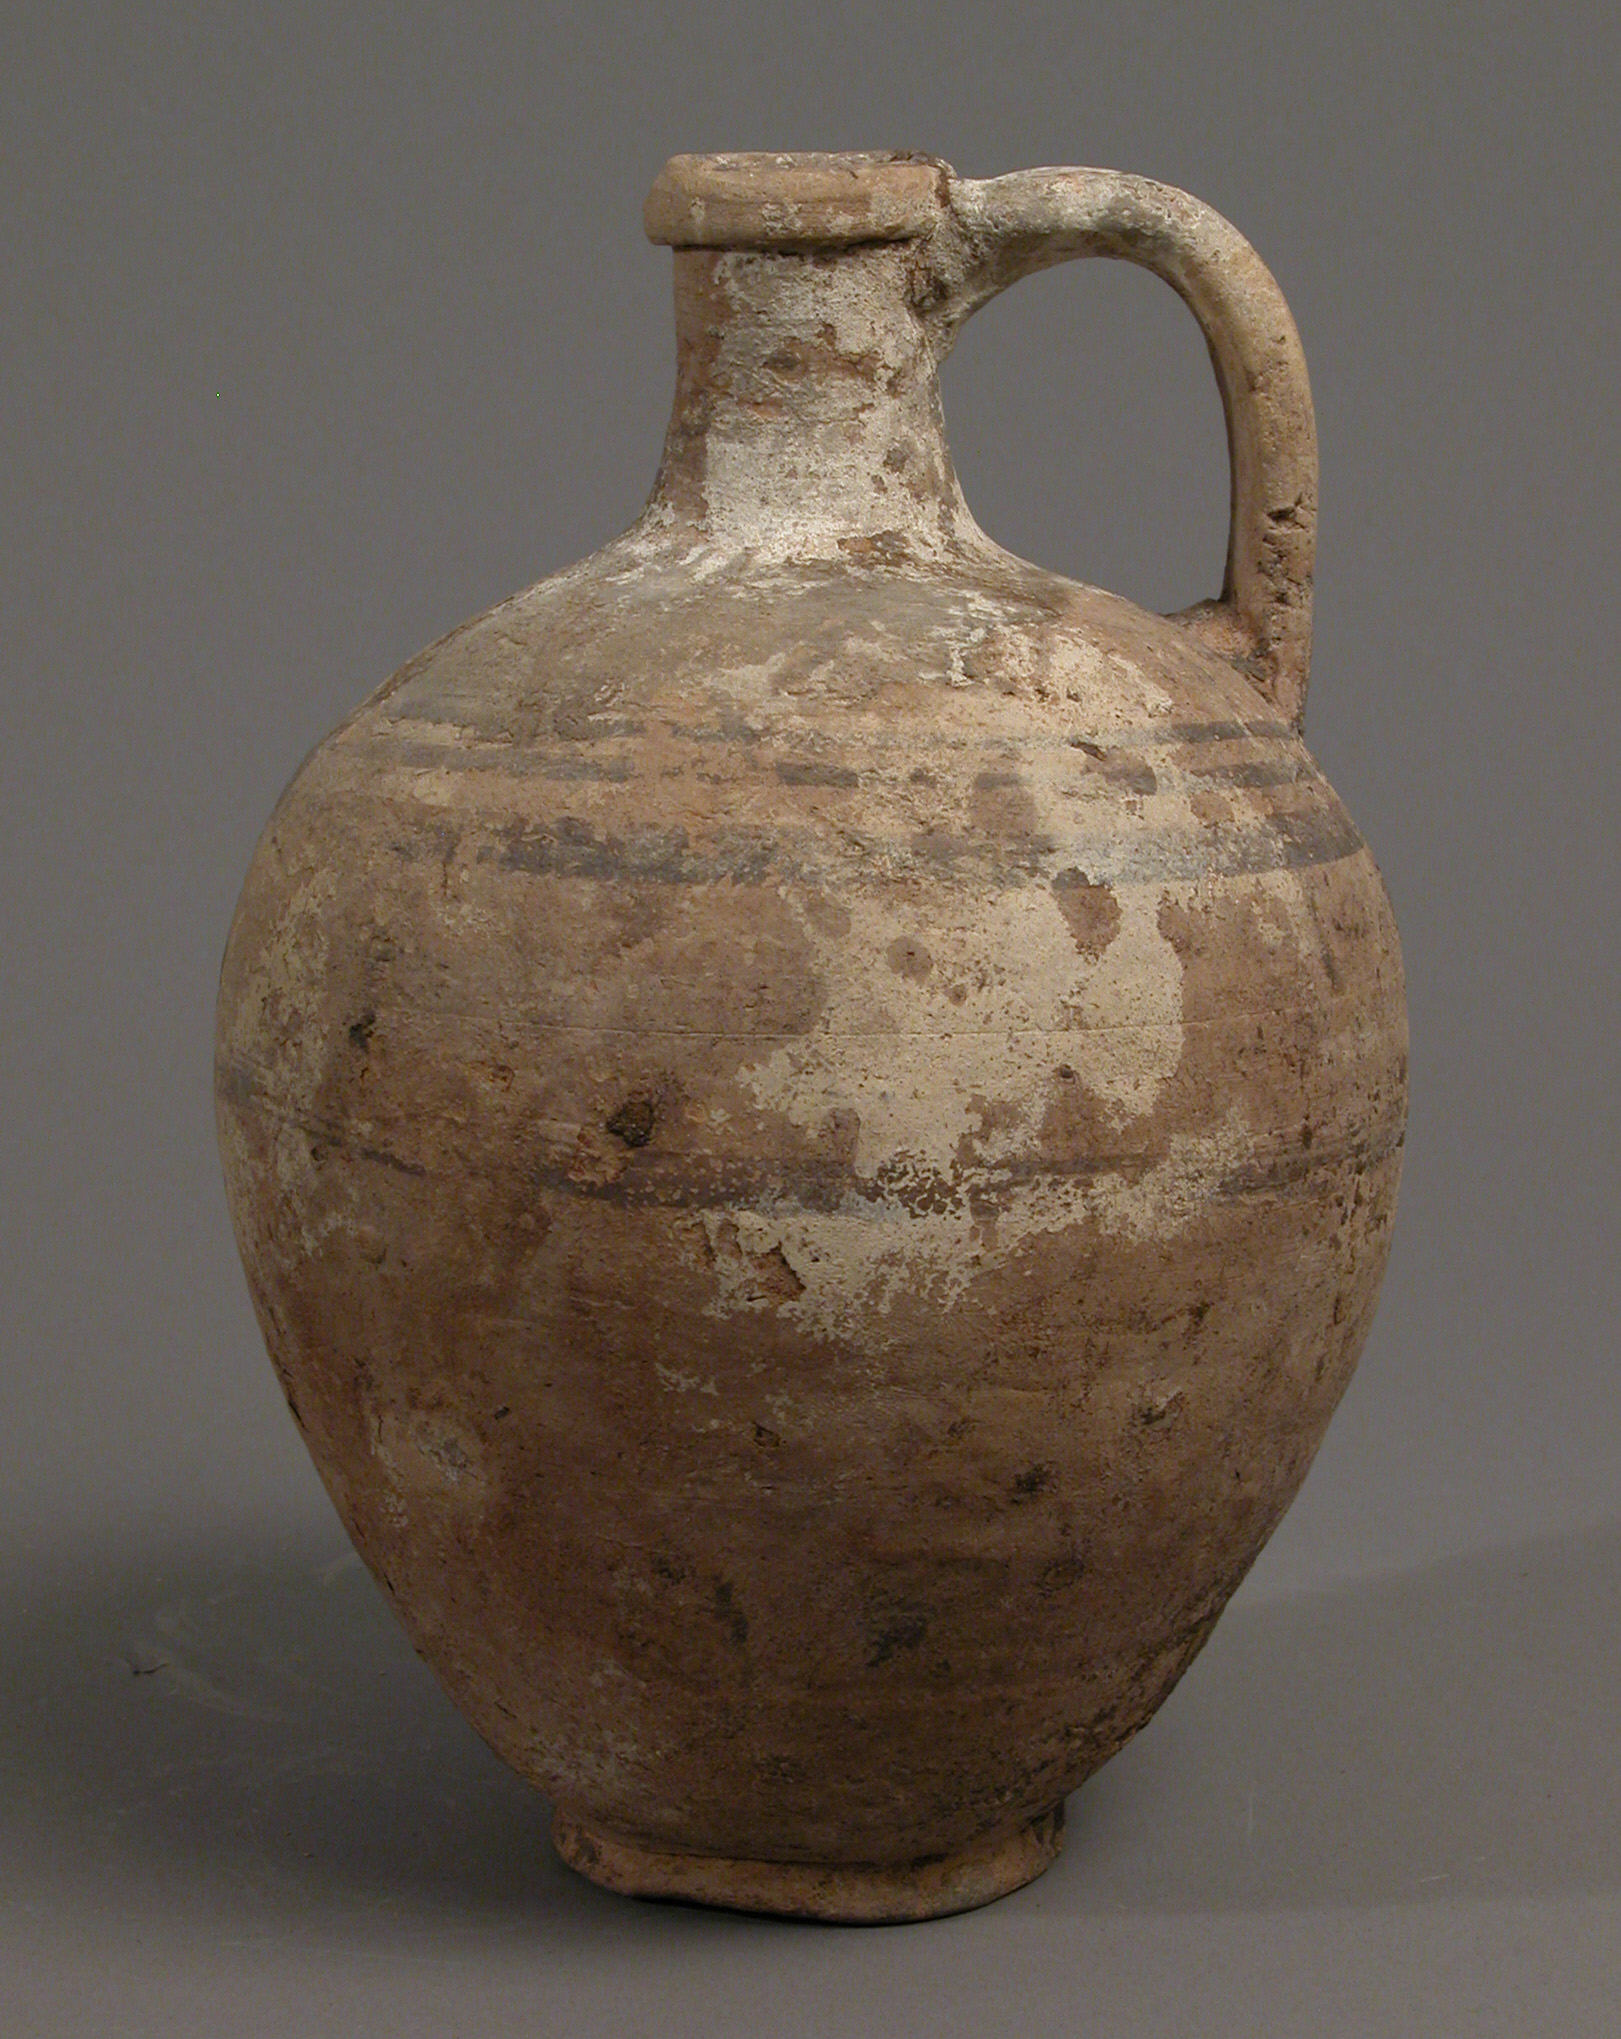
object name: jug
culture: coptic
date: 100 BCE-400 CE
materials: earthenware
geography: egypt